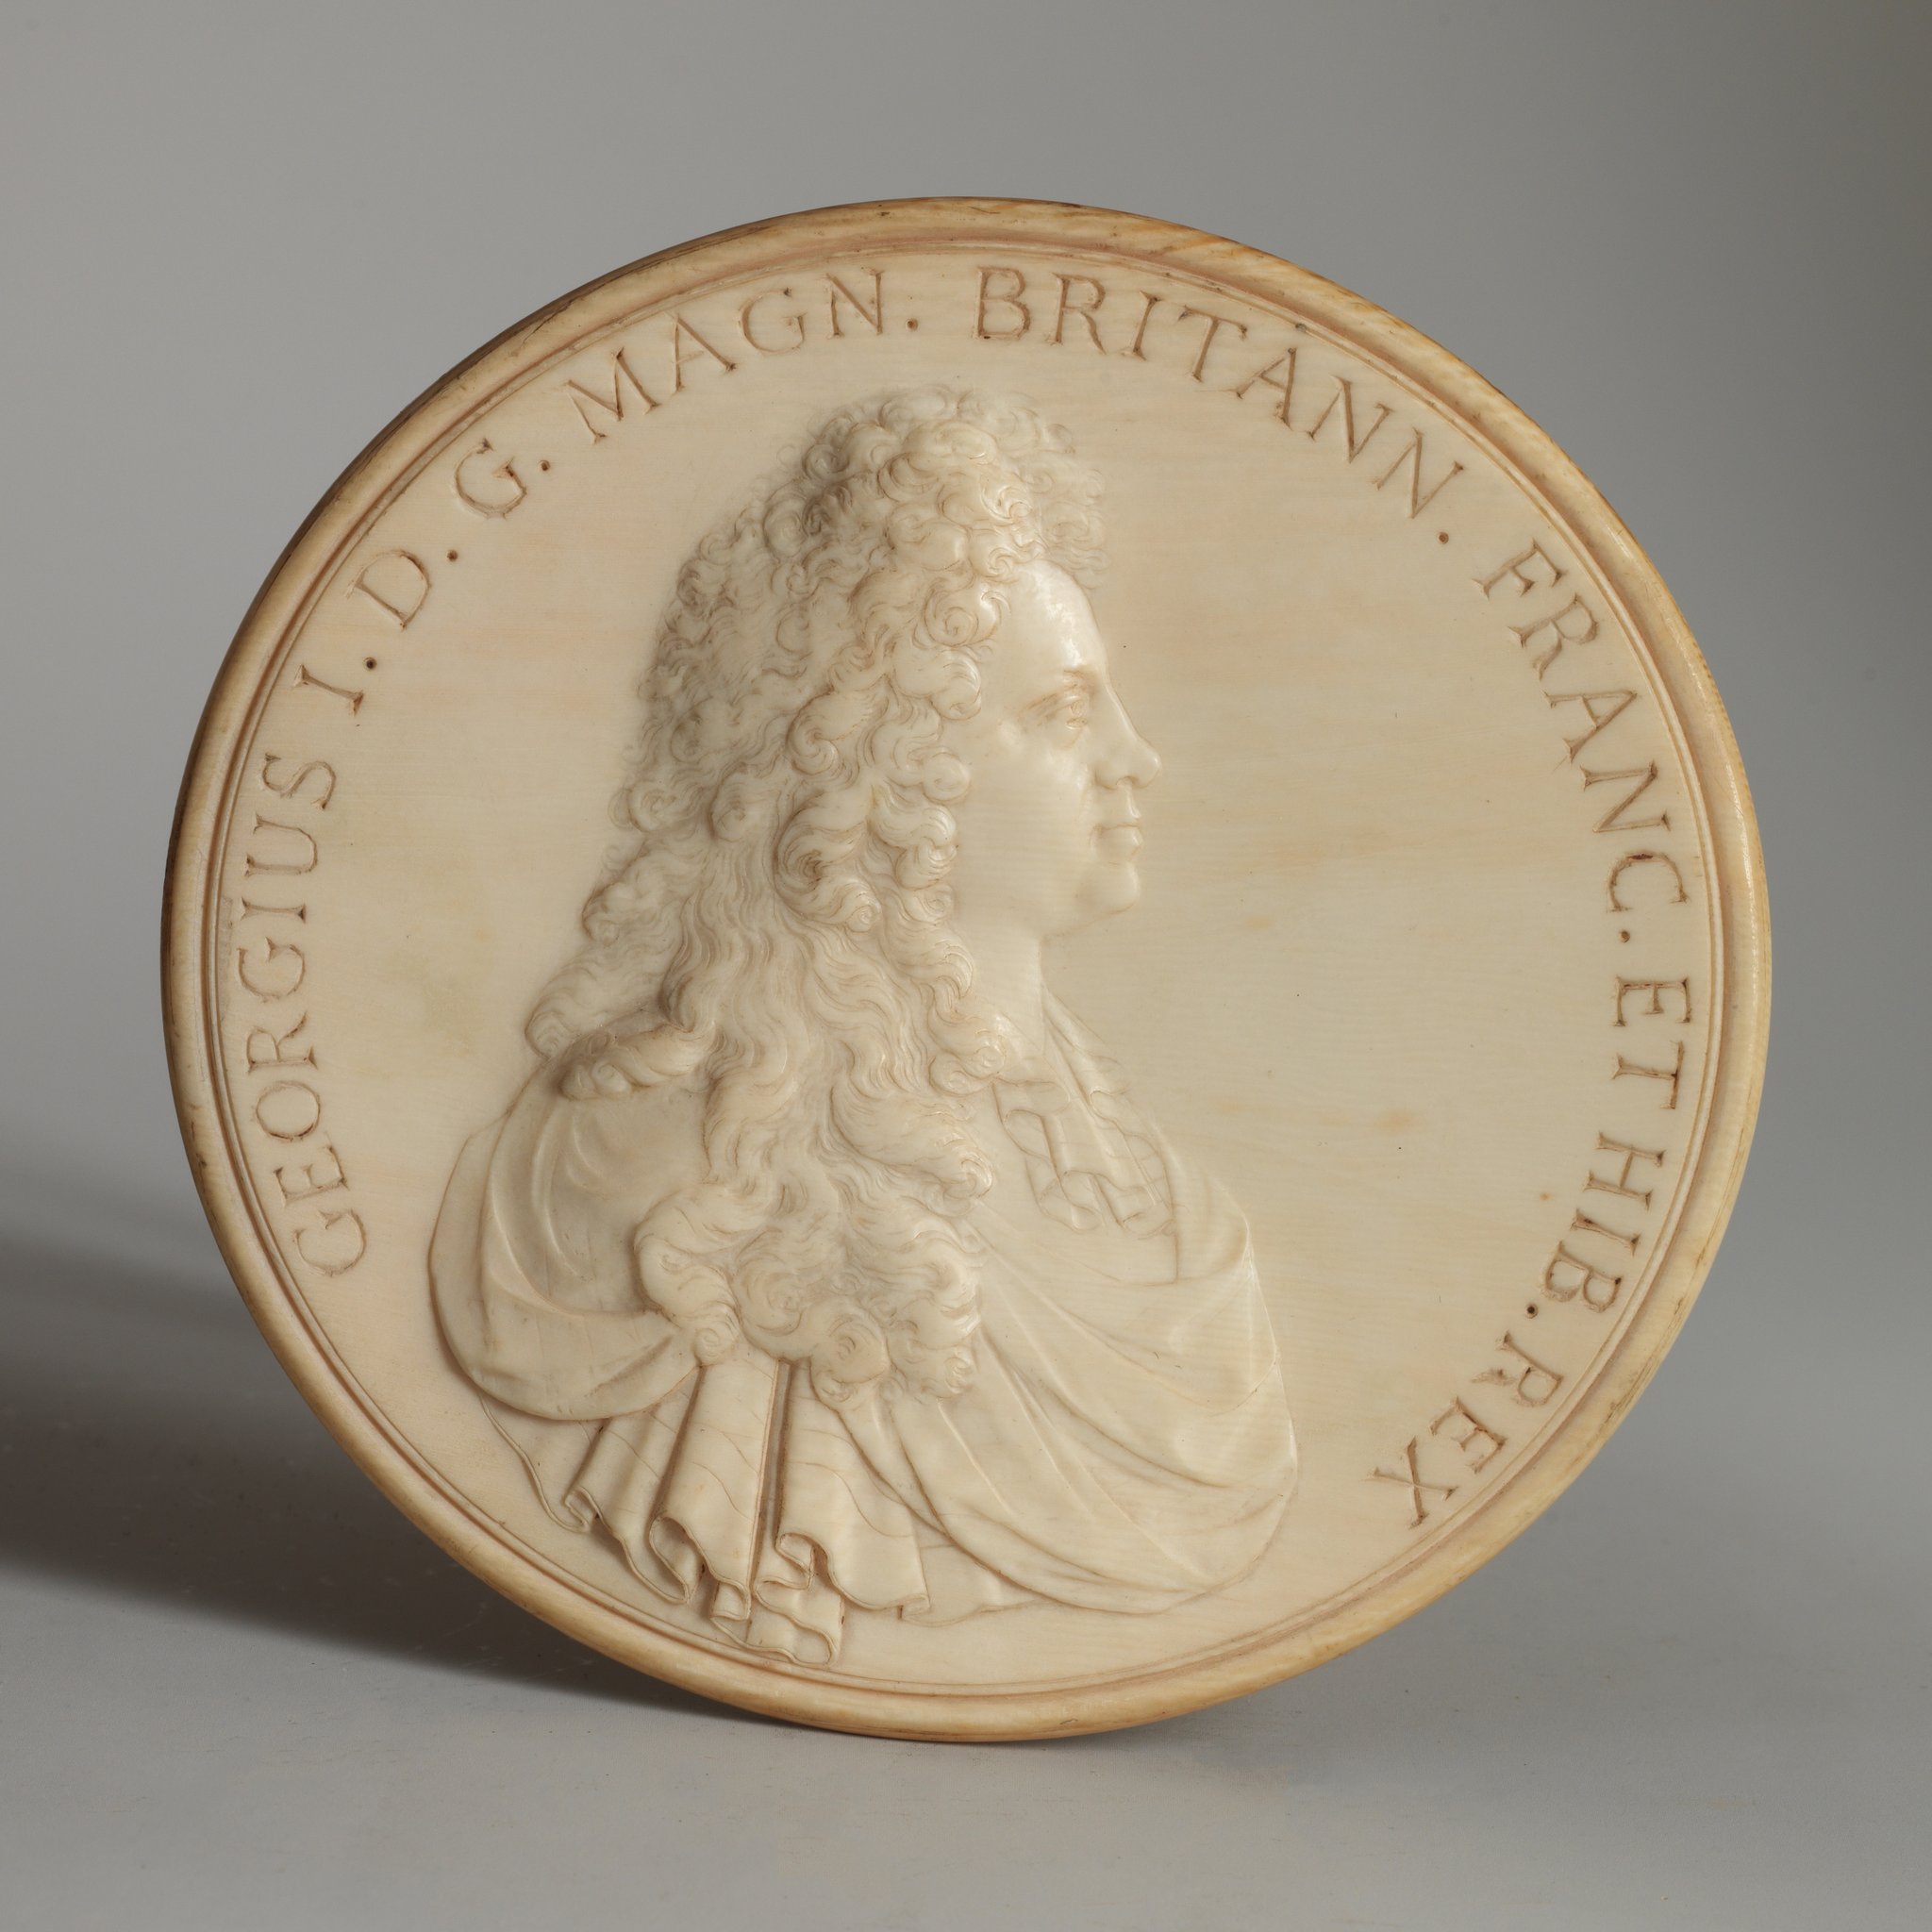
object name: medallion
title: George I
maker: jean cavalier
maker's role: artist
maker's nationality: french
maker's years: 1650-1750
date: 1680-1690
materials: ivory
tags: men,profiles